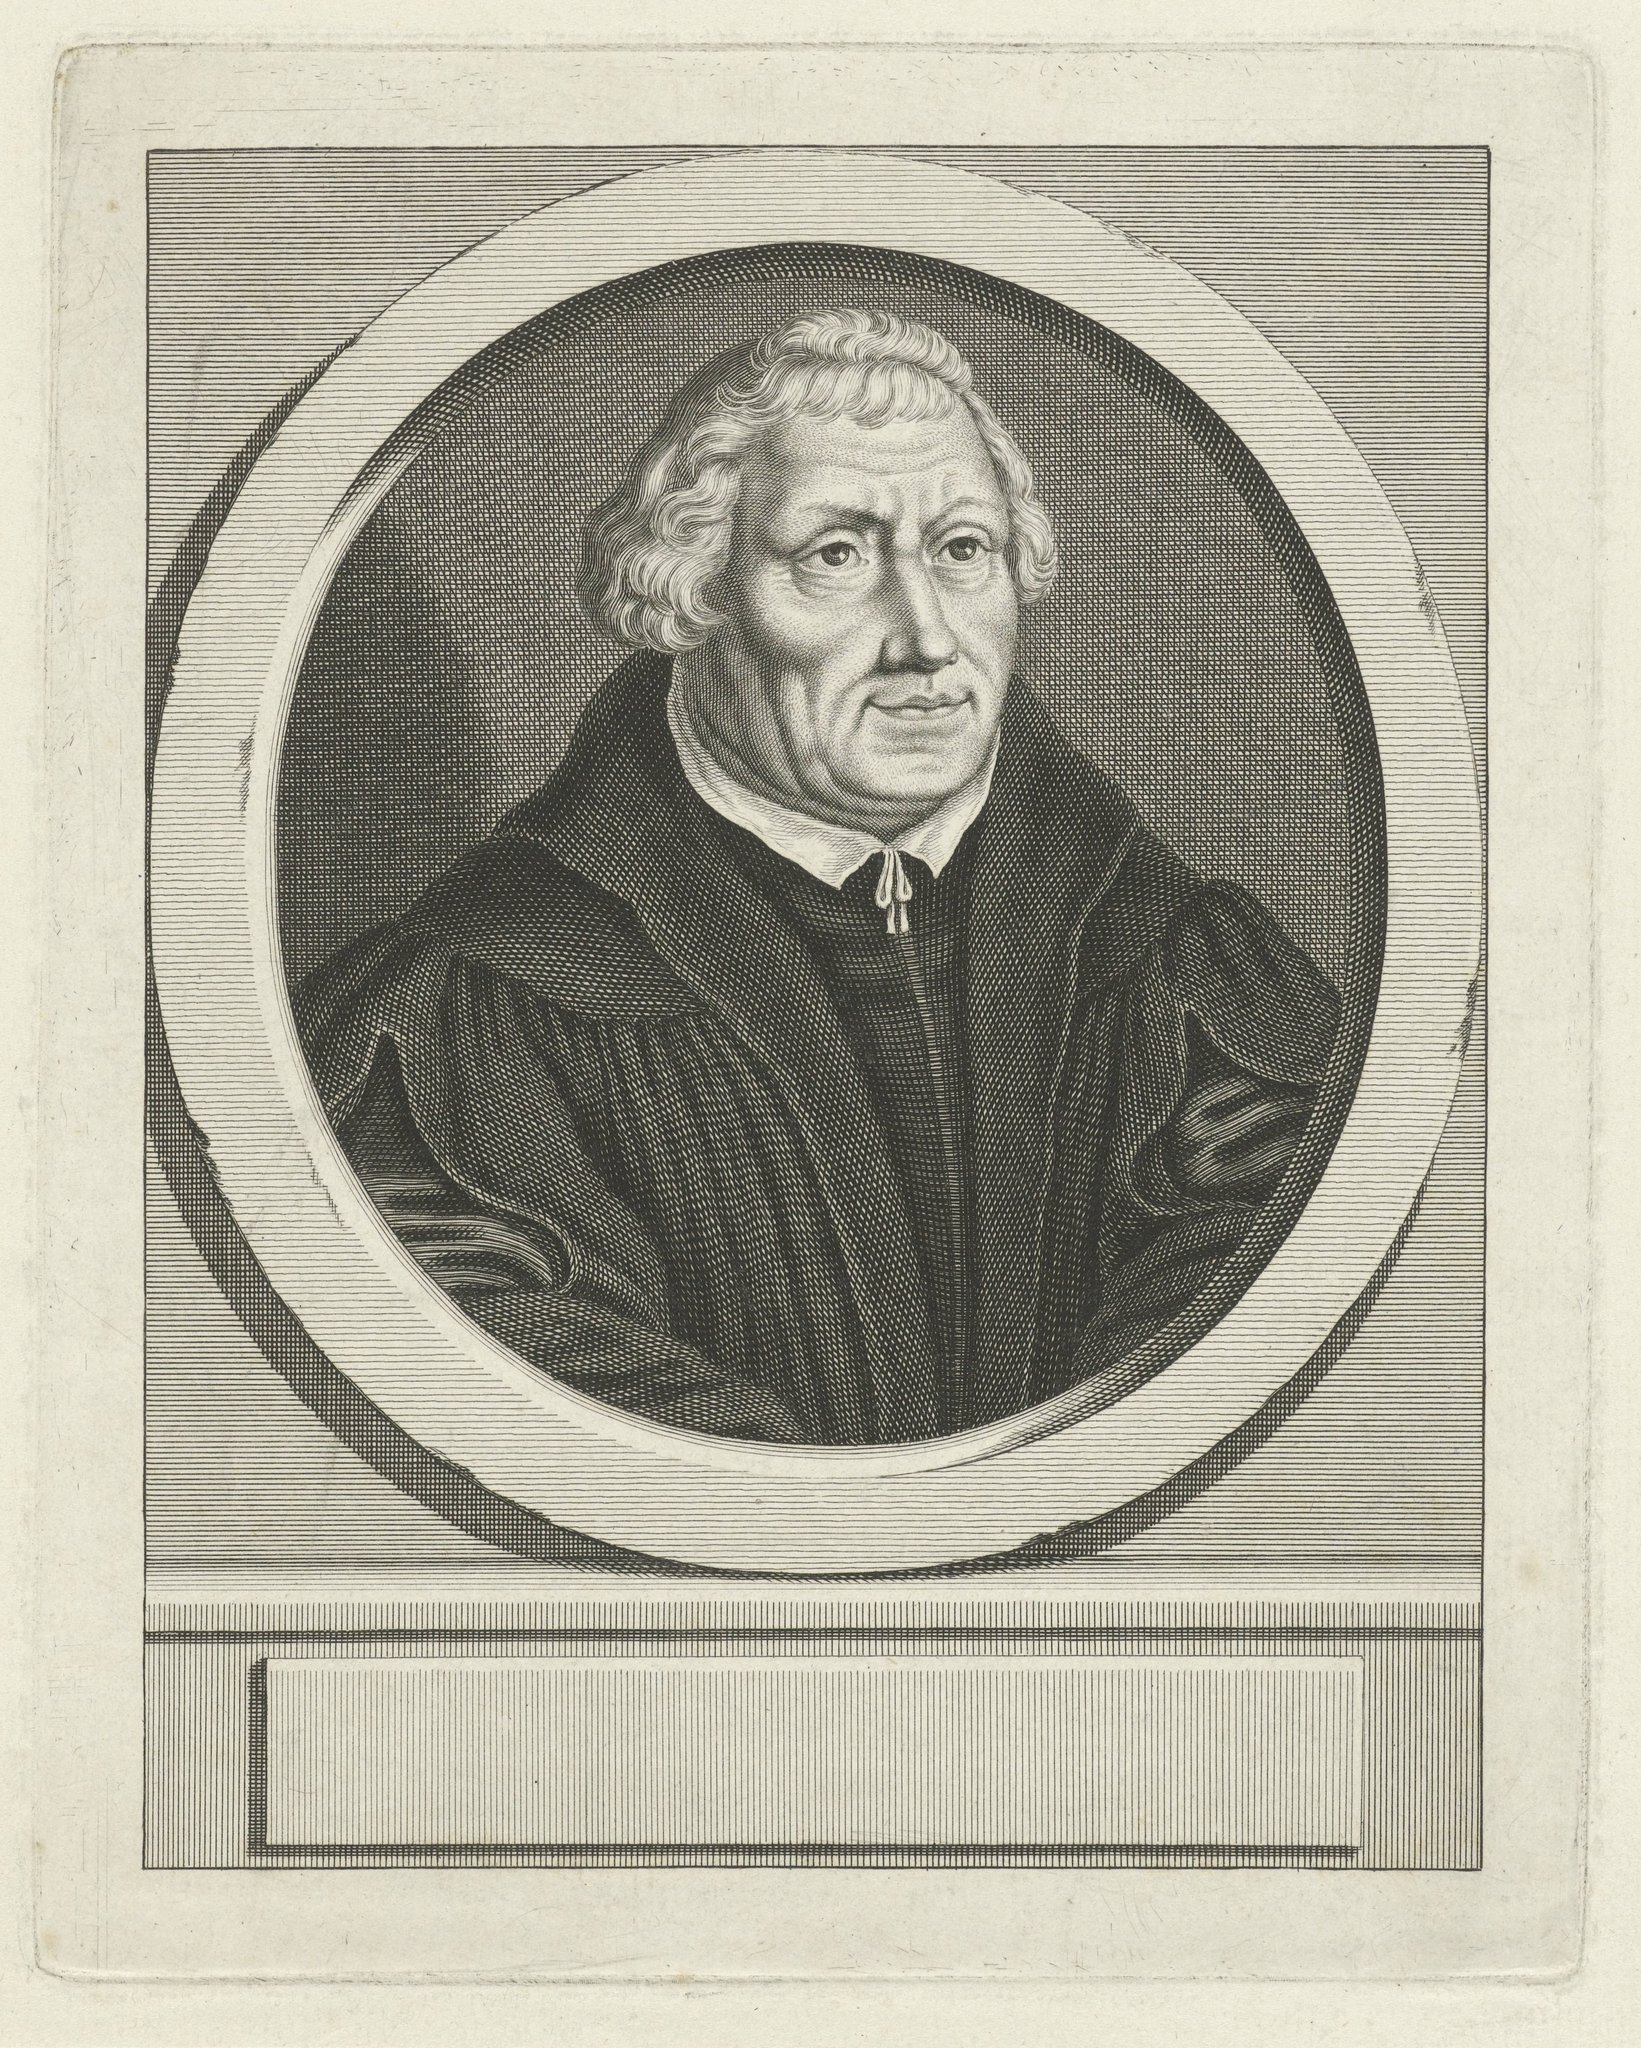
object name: print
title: Portret van Martin Luther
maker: pieter willem van megen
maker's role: print maker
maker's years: 1750-1785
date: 1760-1785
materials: paper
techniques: engraving, etching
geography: the hague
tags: priest, martin luther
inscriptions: collector's mark: Lugt 240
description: Portret van Martin Luther gekleed in een toga.